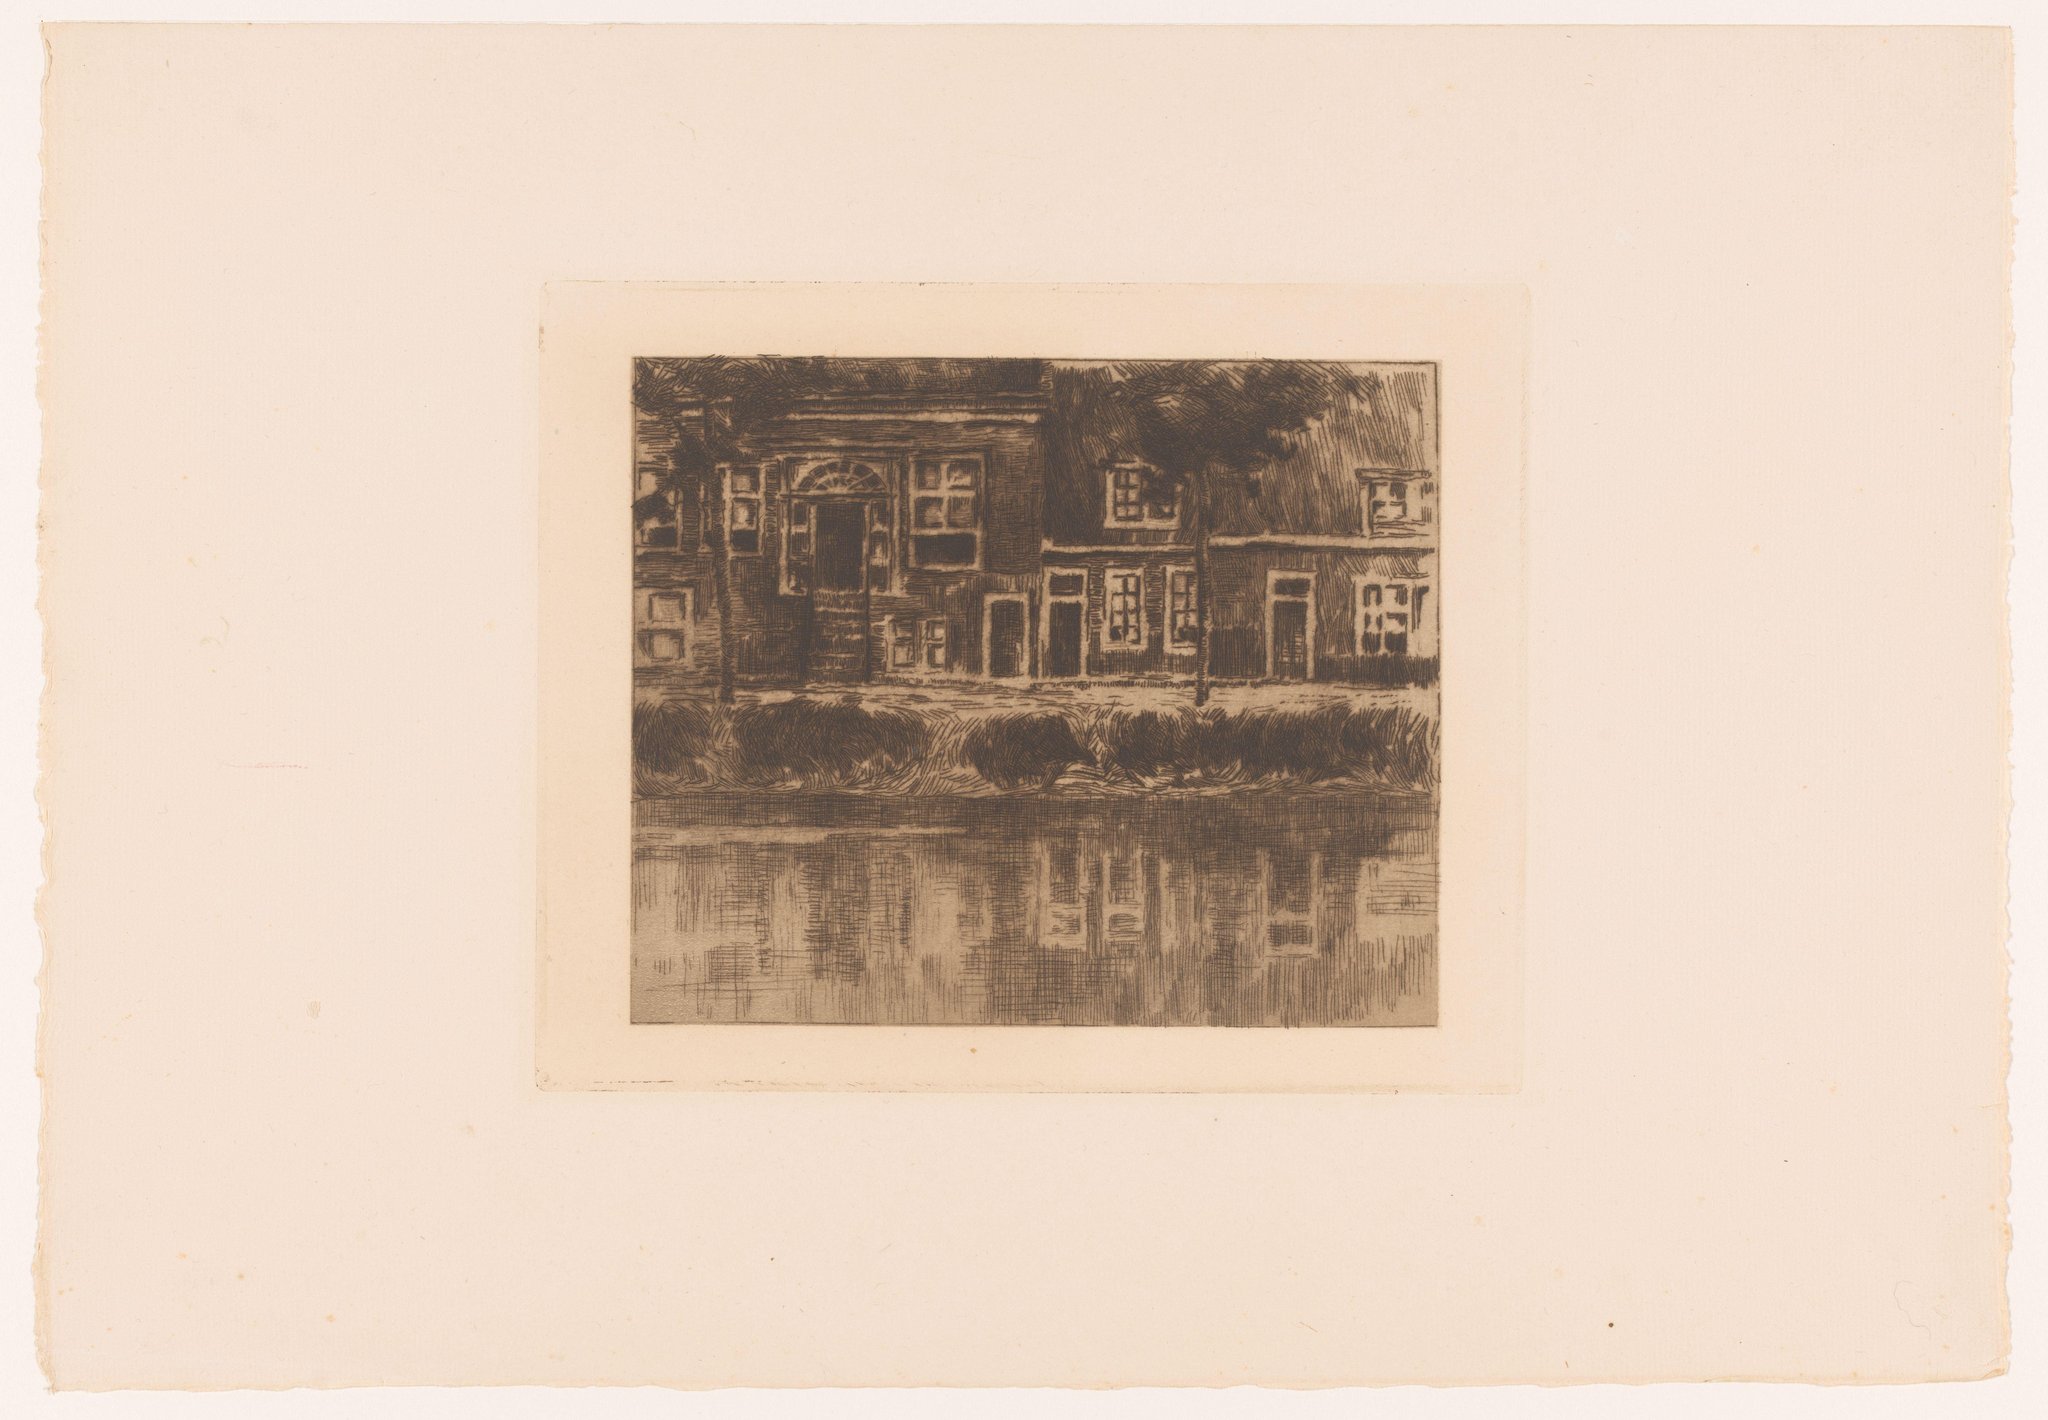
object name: print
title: Kleine Kaai - Middelburg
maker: albert baertsoen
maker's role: draughtsman, print maker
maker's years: 1866-1922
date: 1909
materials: paper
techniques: drypoint, intaglio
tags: pier, quay, wharf, middelburg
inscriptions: watermark: ‘Franse lelie met daaronder VGZ’, collector's mark: Lugt 2760, collector's mark: Lugt 2228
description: Deze prent komt voor in: Kunst van Heden 1909, nr. 1.